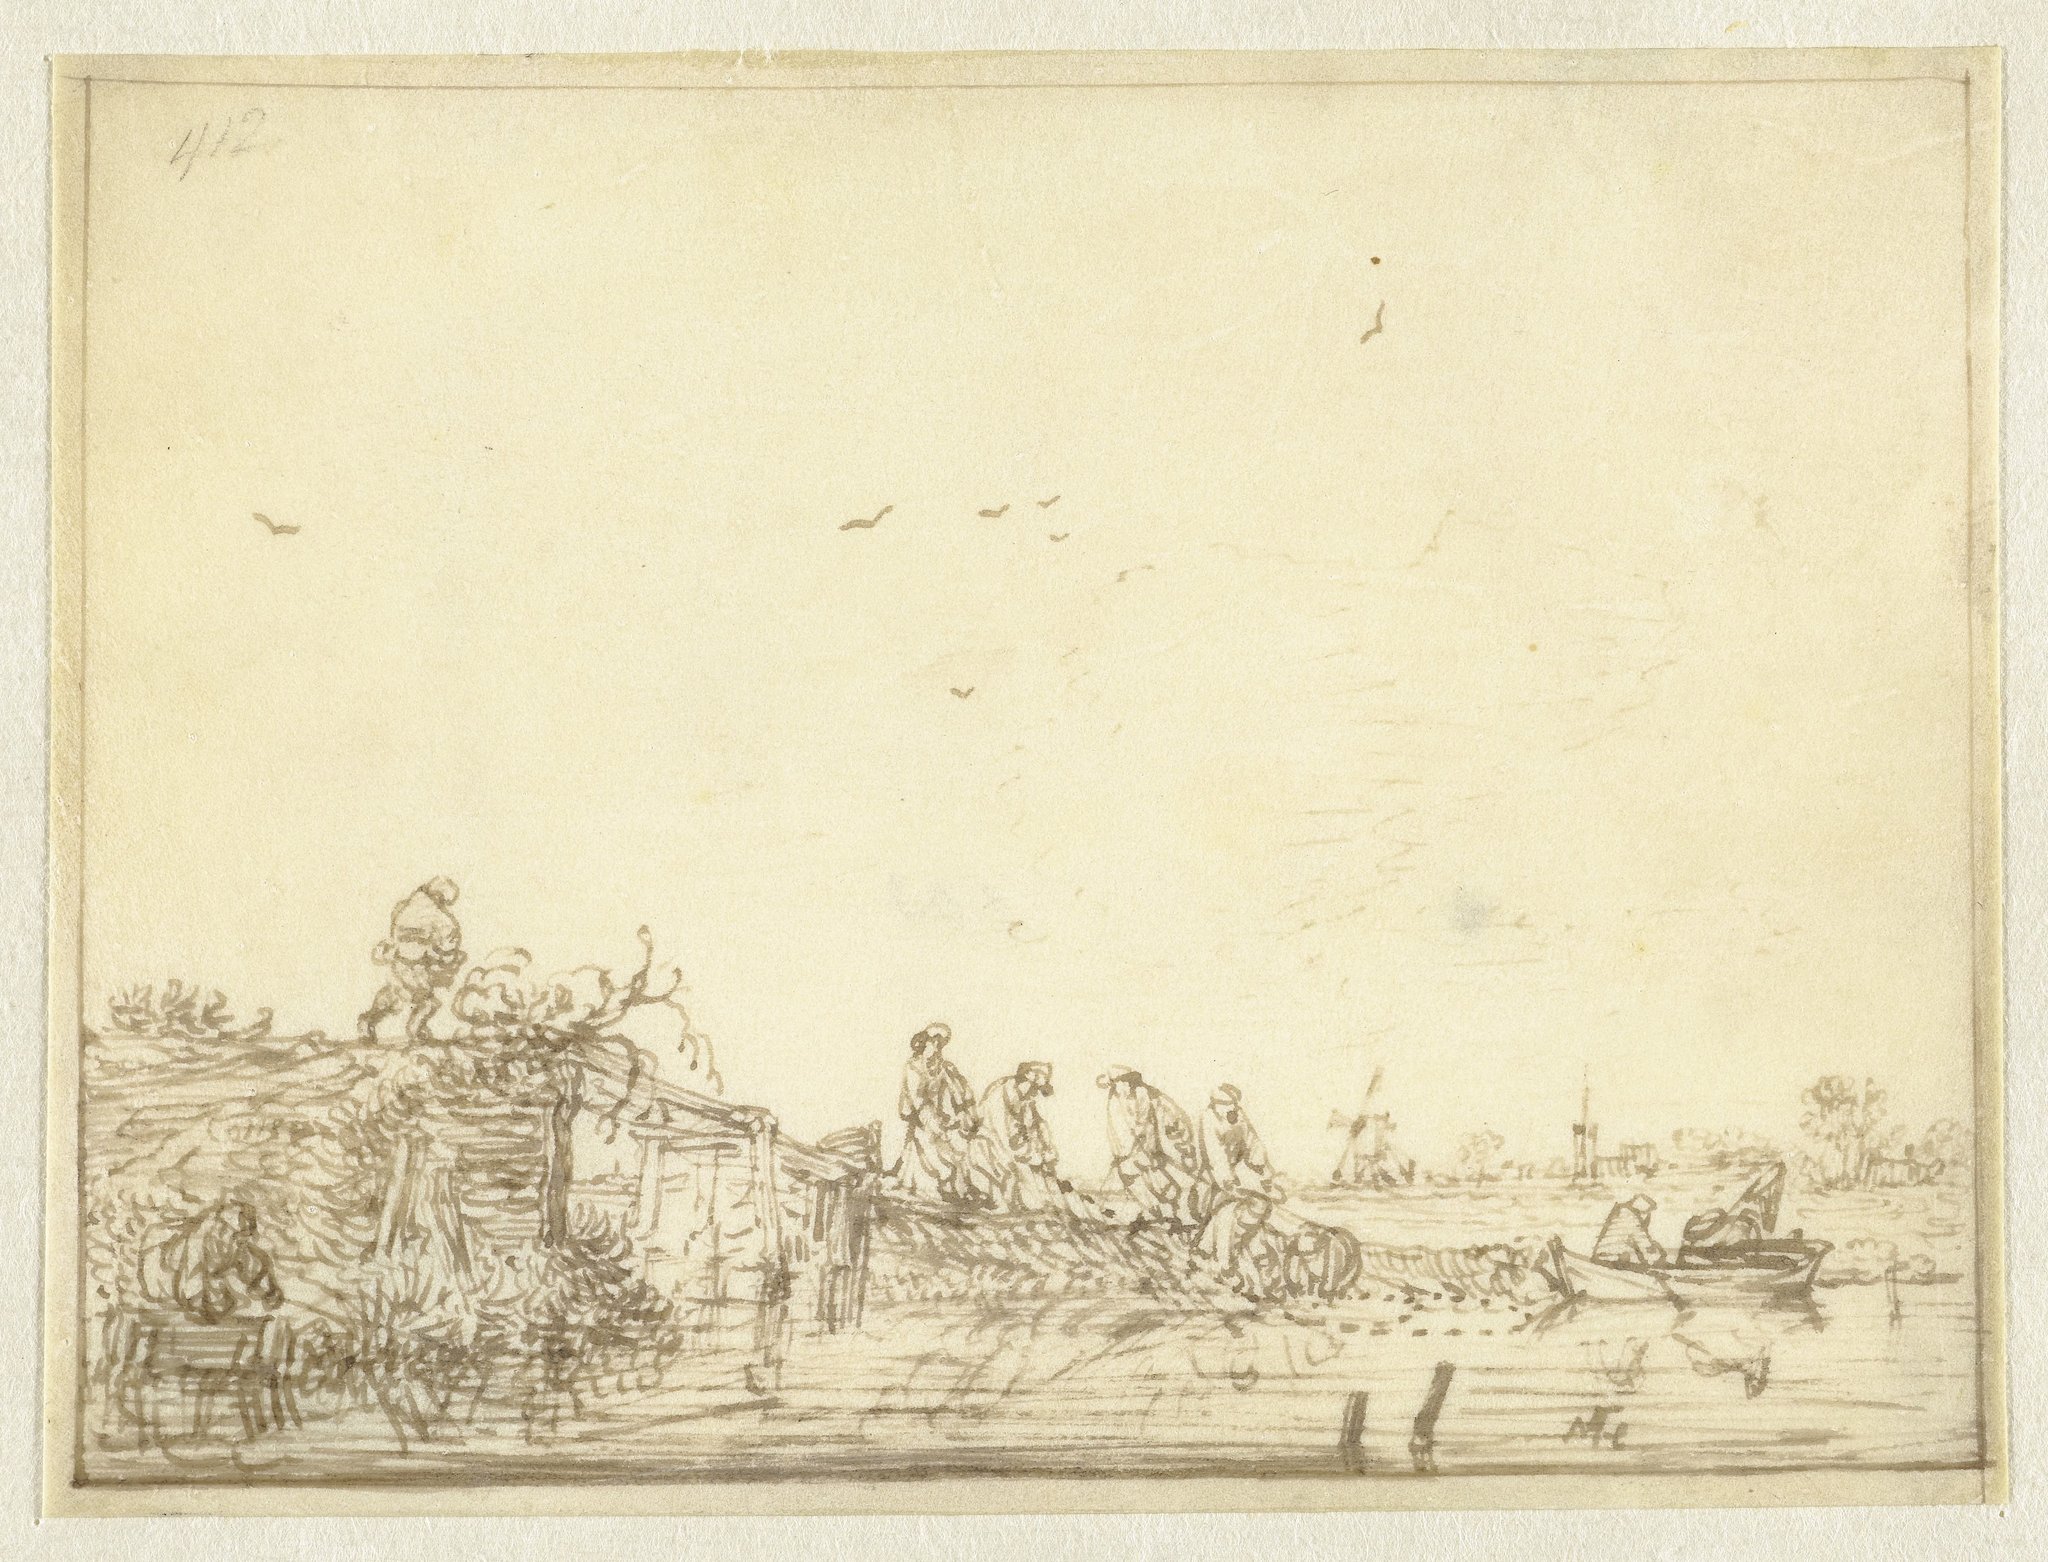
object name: drawing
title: Rivierlandschap met vissers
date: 1610-1660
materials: ink, parchment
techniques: pen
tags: river, fresh-water fishery, landscape with bridge, viaduct or aqueduct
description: Rivierlandschap met links een brug, in het midden vissers die een net ophalen en rechts een visser in een roeibootje.